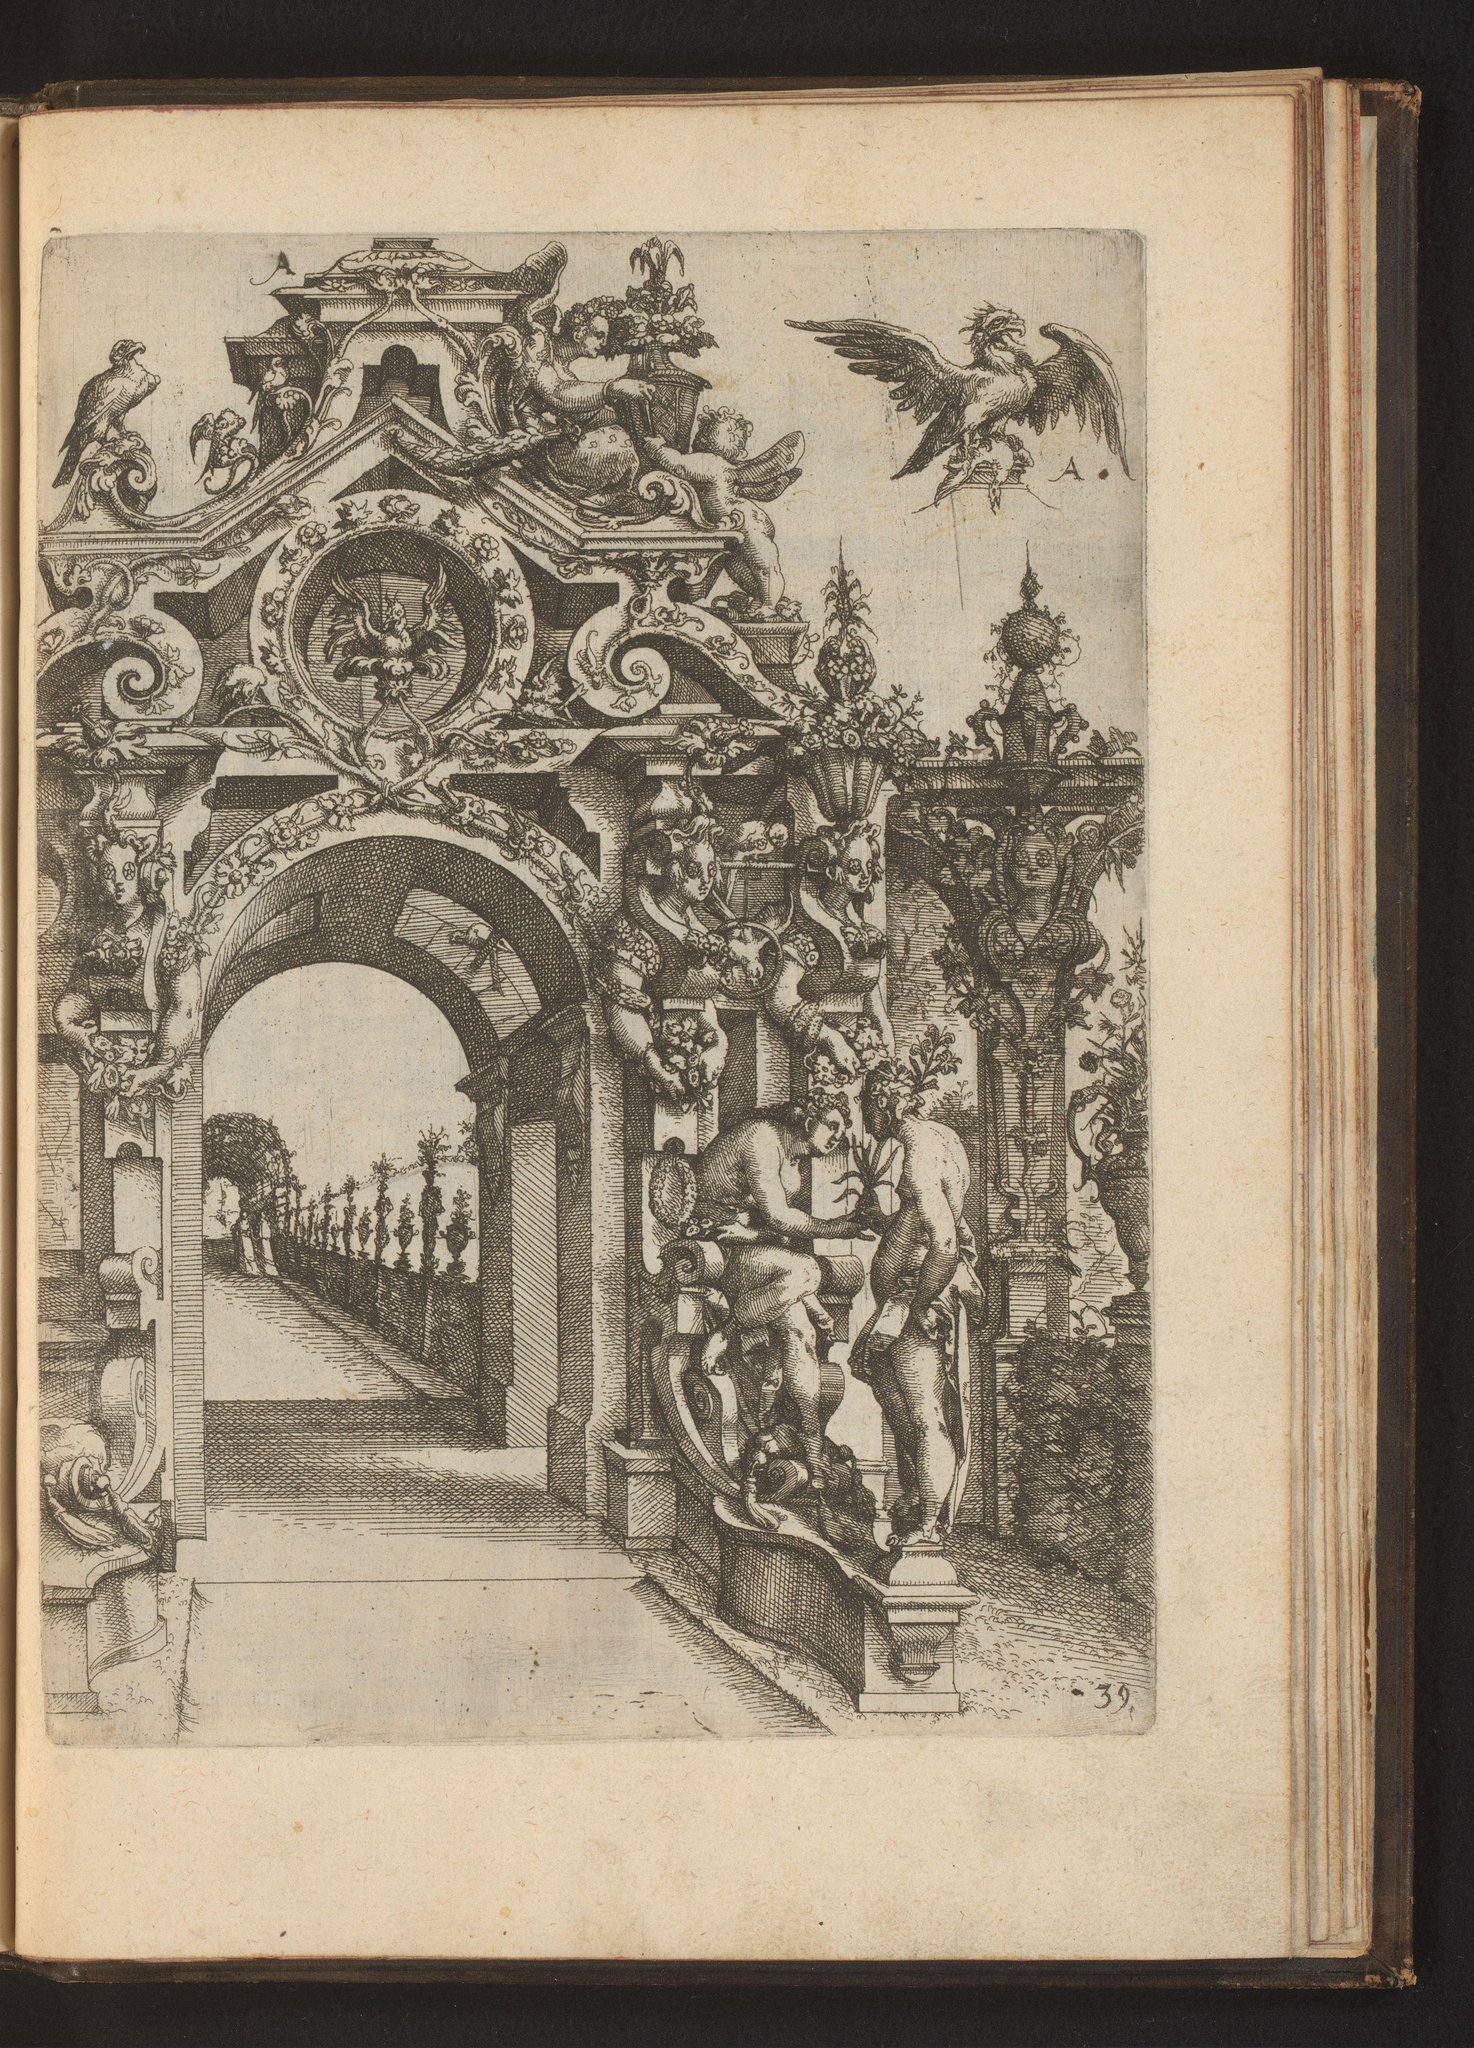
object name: page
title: Tuinpoort gedecoreerd met vrouwelijke hermen, guirlandes, standbeelden en dieren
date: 1593-1595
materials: paper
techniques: etching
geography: straatsburg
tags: parts of church exterior and annexes: portal, pedestal of a piece of sculpture (perhaps in the form of a herm), ornament derived from architectural details, public gardens, park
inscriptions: collector's mark: Lugt 2228, collector's mark: Lugt 2760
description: Prent gebruikt in: Dietterlin, Wendel (I). Wendel Dietterlin, Architectura de Polstium seu Portalium ornatu uario Liber II. Straatsburg: Bernhard Jobin, 1594.